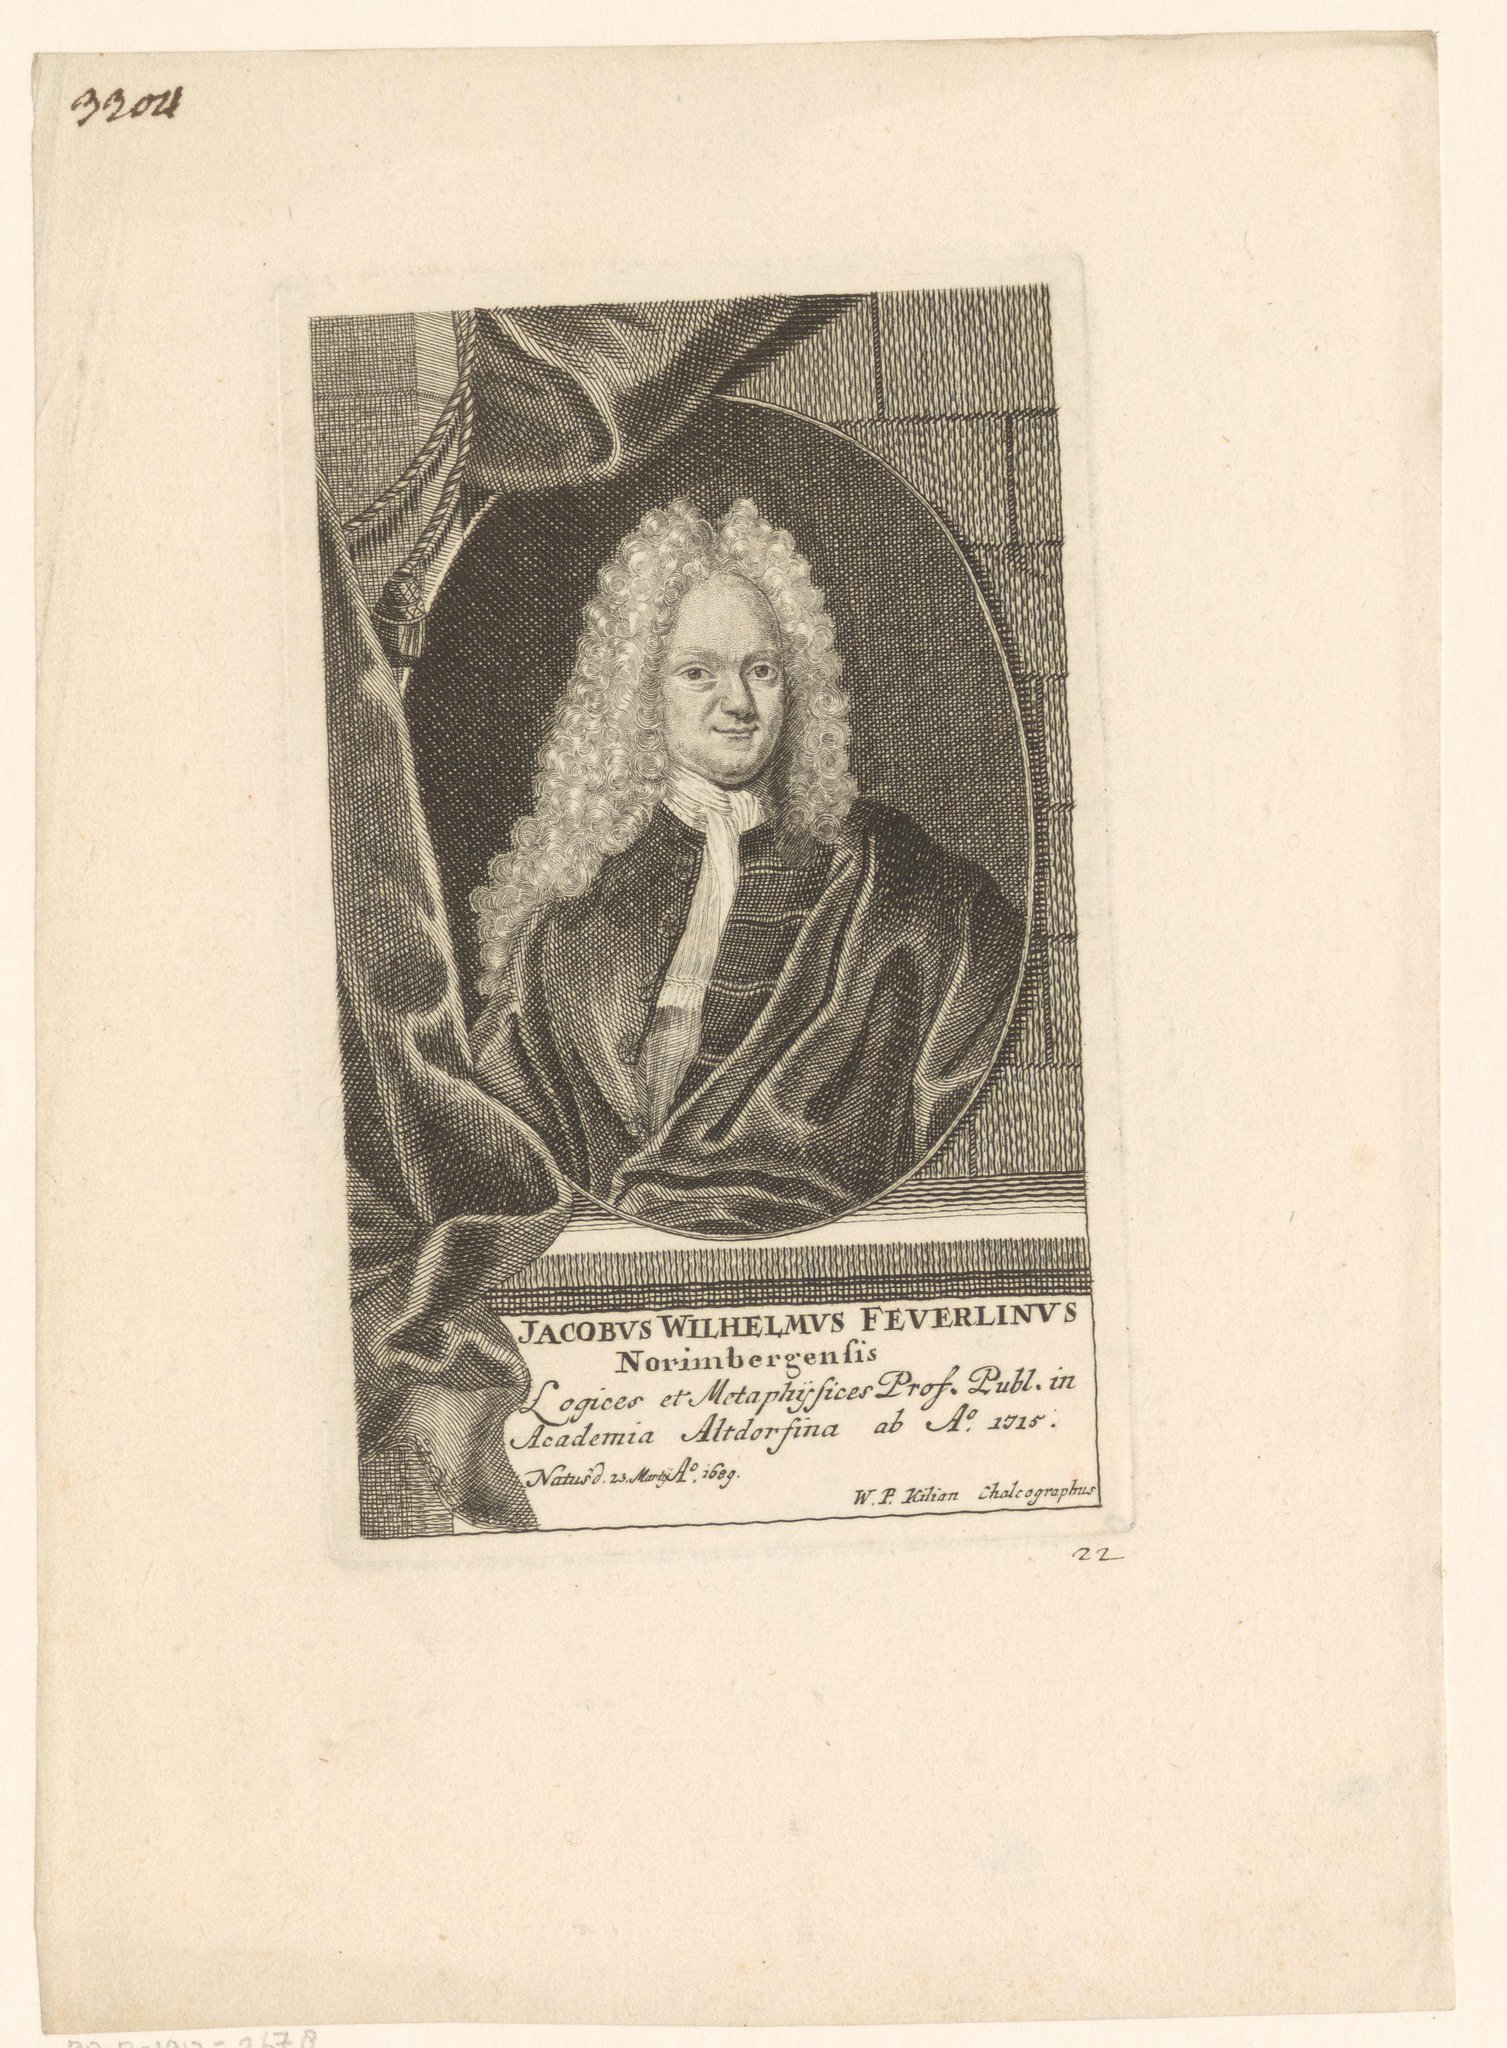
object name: print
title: Portret van Jacob Wilhelm Feuerlein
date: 1715-1732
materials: paper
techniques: engraving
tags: theologian, further education (+ portrait of teacher, professor), historical persons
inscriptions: collector's mark: Lugt 2228, number: ‘22’